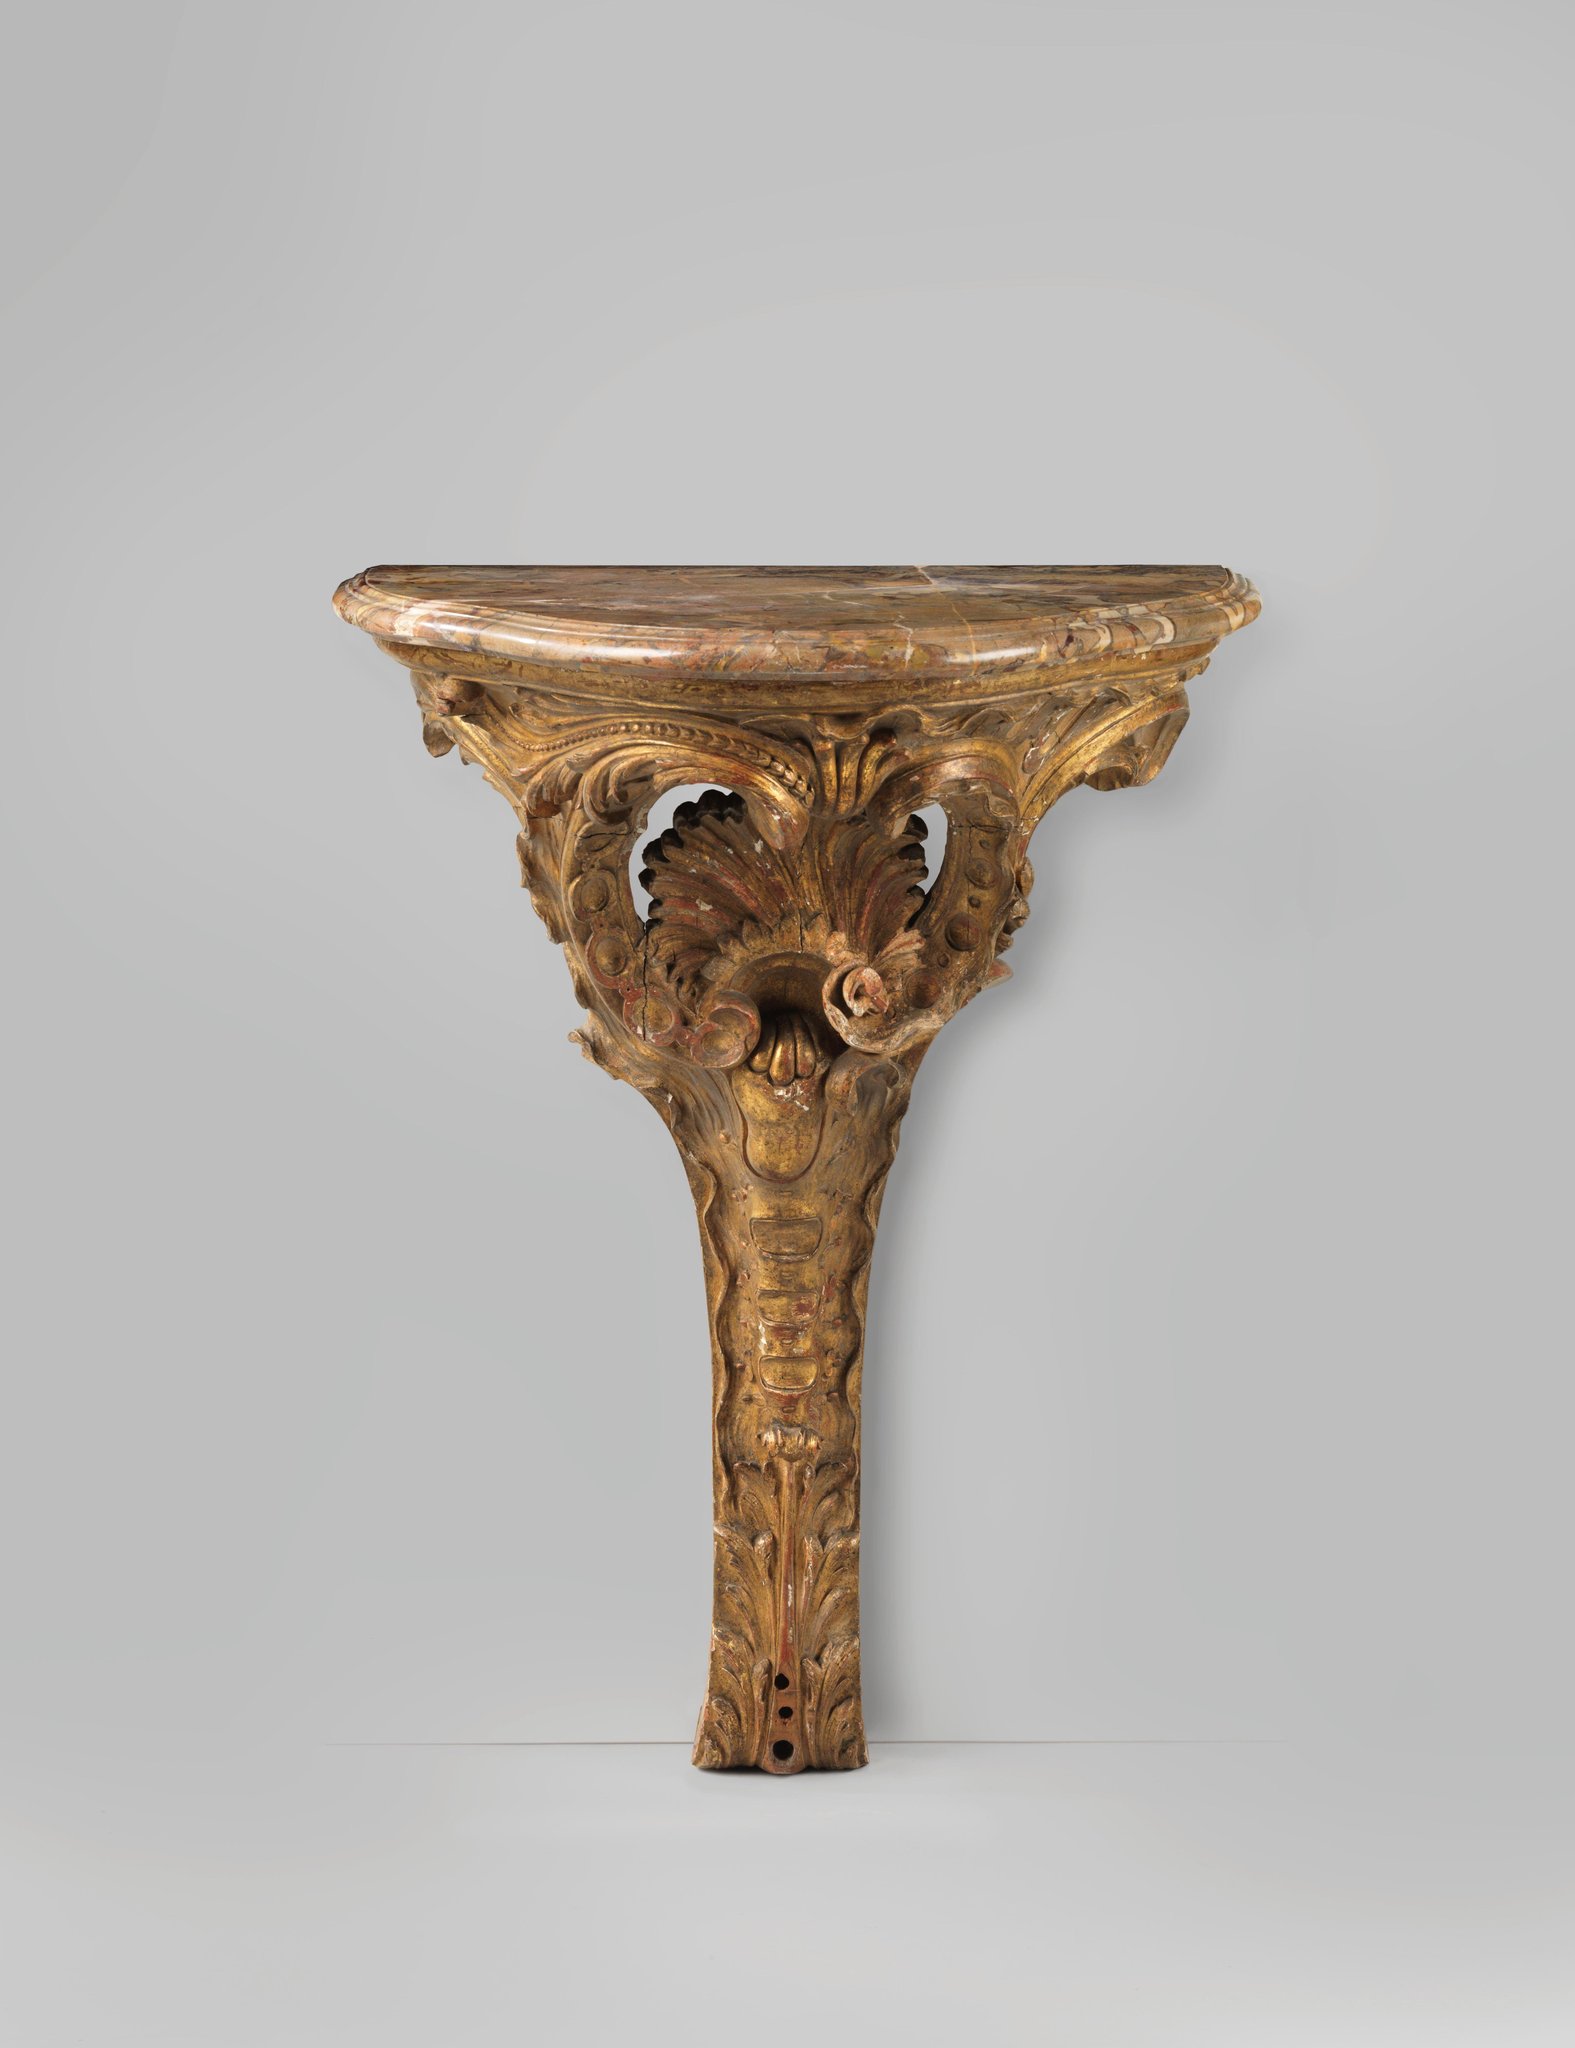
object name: table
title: Consoletafel van verguld lindehout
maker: Anonymous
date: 1750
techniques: gilding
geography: france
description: Onderstel van consoletafel van verguld lindehout. De geschulpte, geprofileerde marmeren dekplaat wordt gedragen door twee toegewende gesneden C-voluten, die een kuifschelp flankeren; links en rechts nog twee C-voluten. Het geheel rust op een onderstuk dat bestaat uit een groot acanthusblad, waarboven een rupsvormig motief. Zie tevens: BK-16855-B.